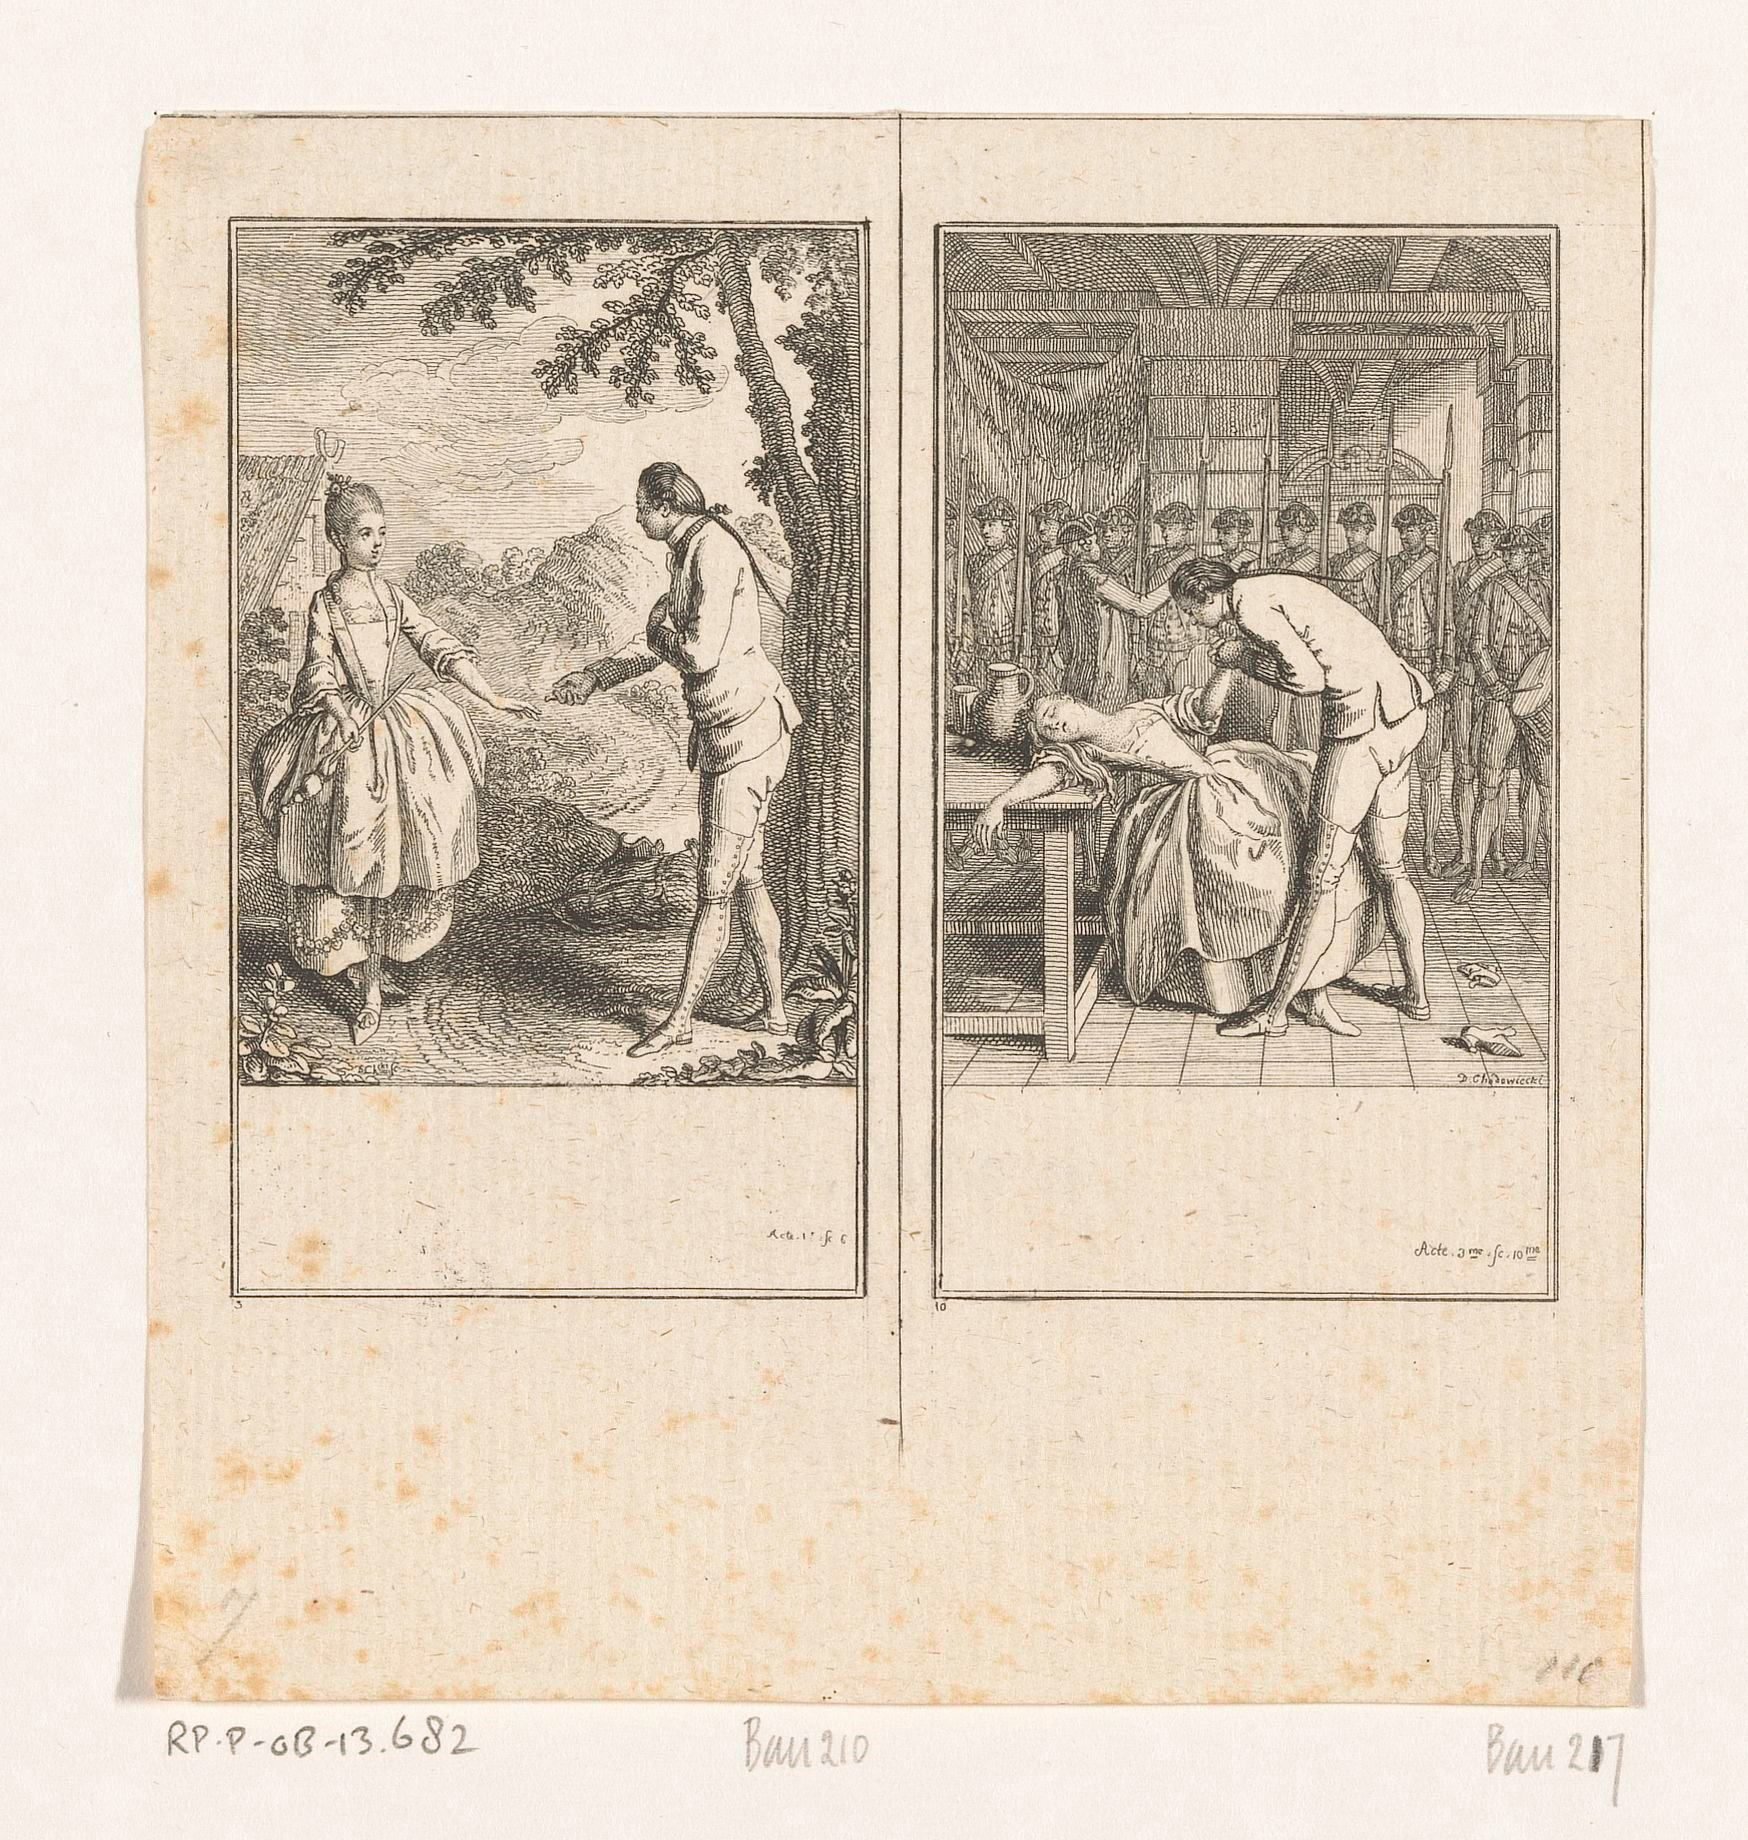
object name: print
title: Twee scènes uit de Deserteur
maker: daniel nikolaus chodowiecki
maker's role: draughtsman, print maker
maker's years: 1726-1801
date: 1774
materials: paper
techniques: etching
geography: berlin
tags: paris, fainting, swooning, literature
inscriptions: collector's mark: Lugt 2228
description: Derde en tiende scène uit een serie van twaalf scènes die de opéra comique 'Le déserteur' door Michel-Jean Sedaine illustreren. De scènes werden op een plaat geëtst. De tweede staat van deze serie werd ook gebruikt in: 'Berliner genealogischen Calender auf das Jahr 1775'.